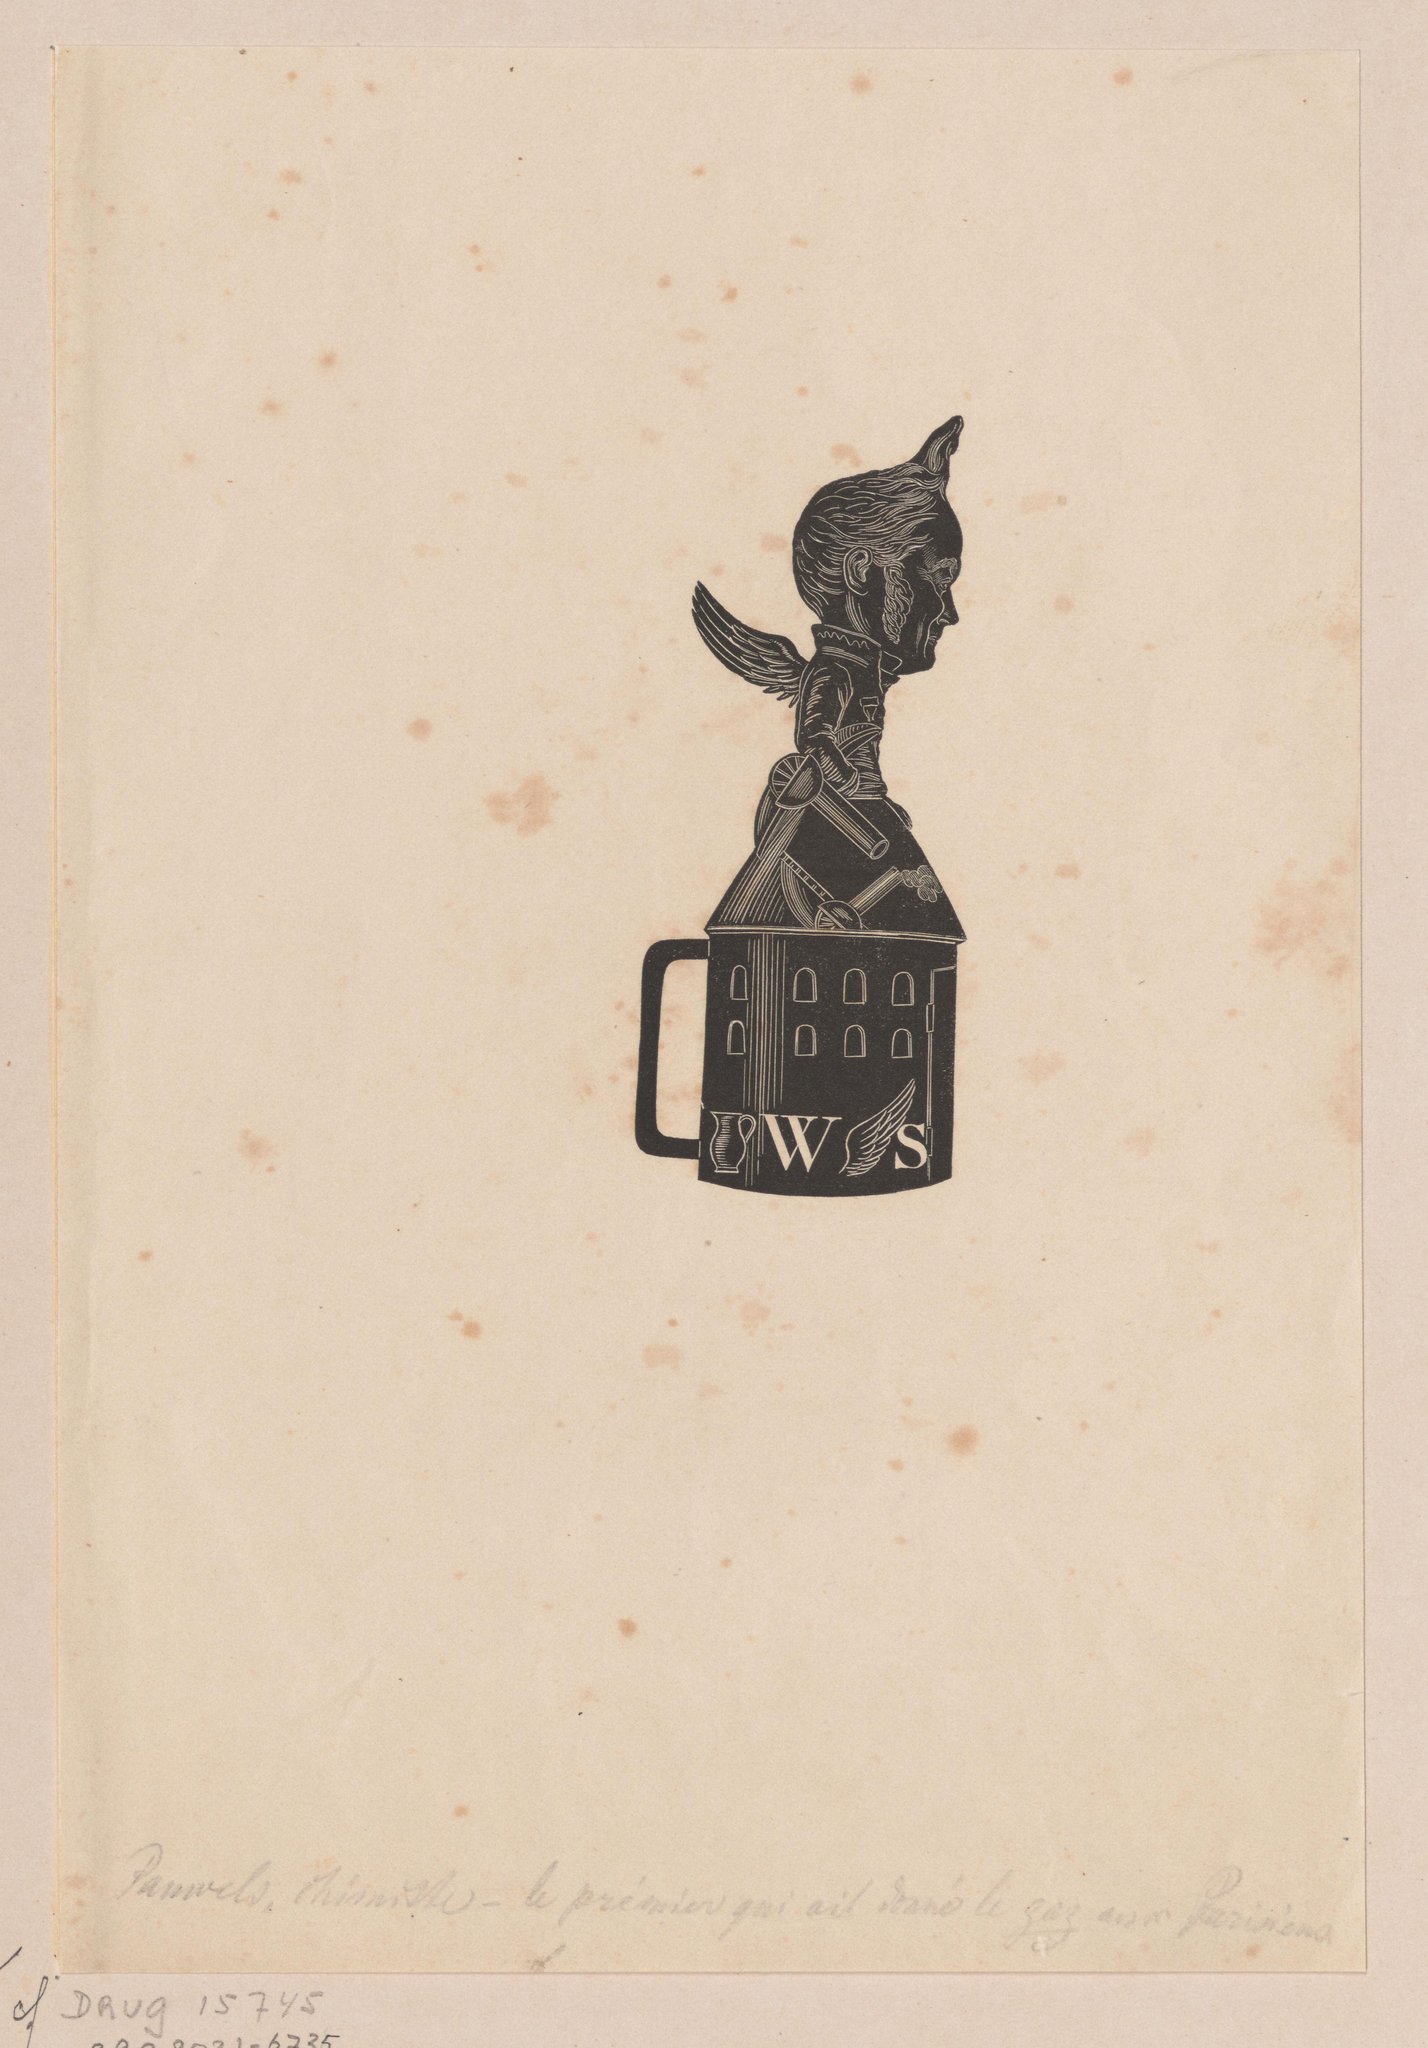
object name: cartoon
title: Karikatuur van Antoine Pauwels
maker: Anonymous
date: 1837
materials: paper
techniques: engraving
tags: machine driven by steam, caricatures (human types), adult man, historical persons, rebus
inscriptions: inscription: ‘Pauwels, chimiste - le premier qui ait donné le gaz aux Parisiens’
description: Karikatuur van Antoine Pauwels, met vleugels op zijn rug en zijn haar in een puntige kuif. Hij steekt uit het dak van een gebouw. Op het dak twee stoommachines. Onder een Franse rebus met een kan/pot, de letter W, een vleugel en de letter S. De oplossing is een fonetische variant van zijn achternaam: [pot]W[aile]S.